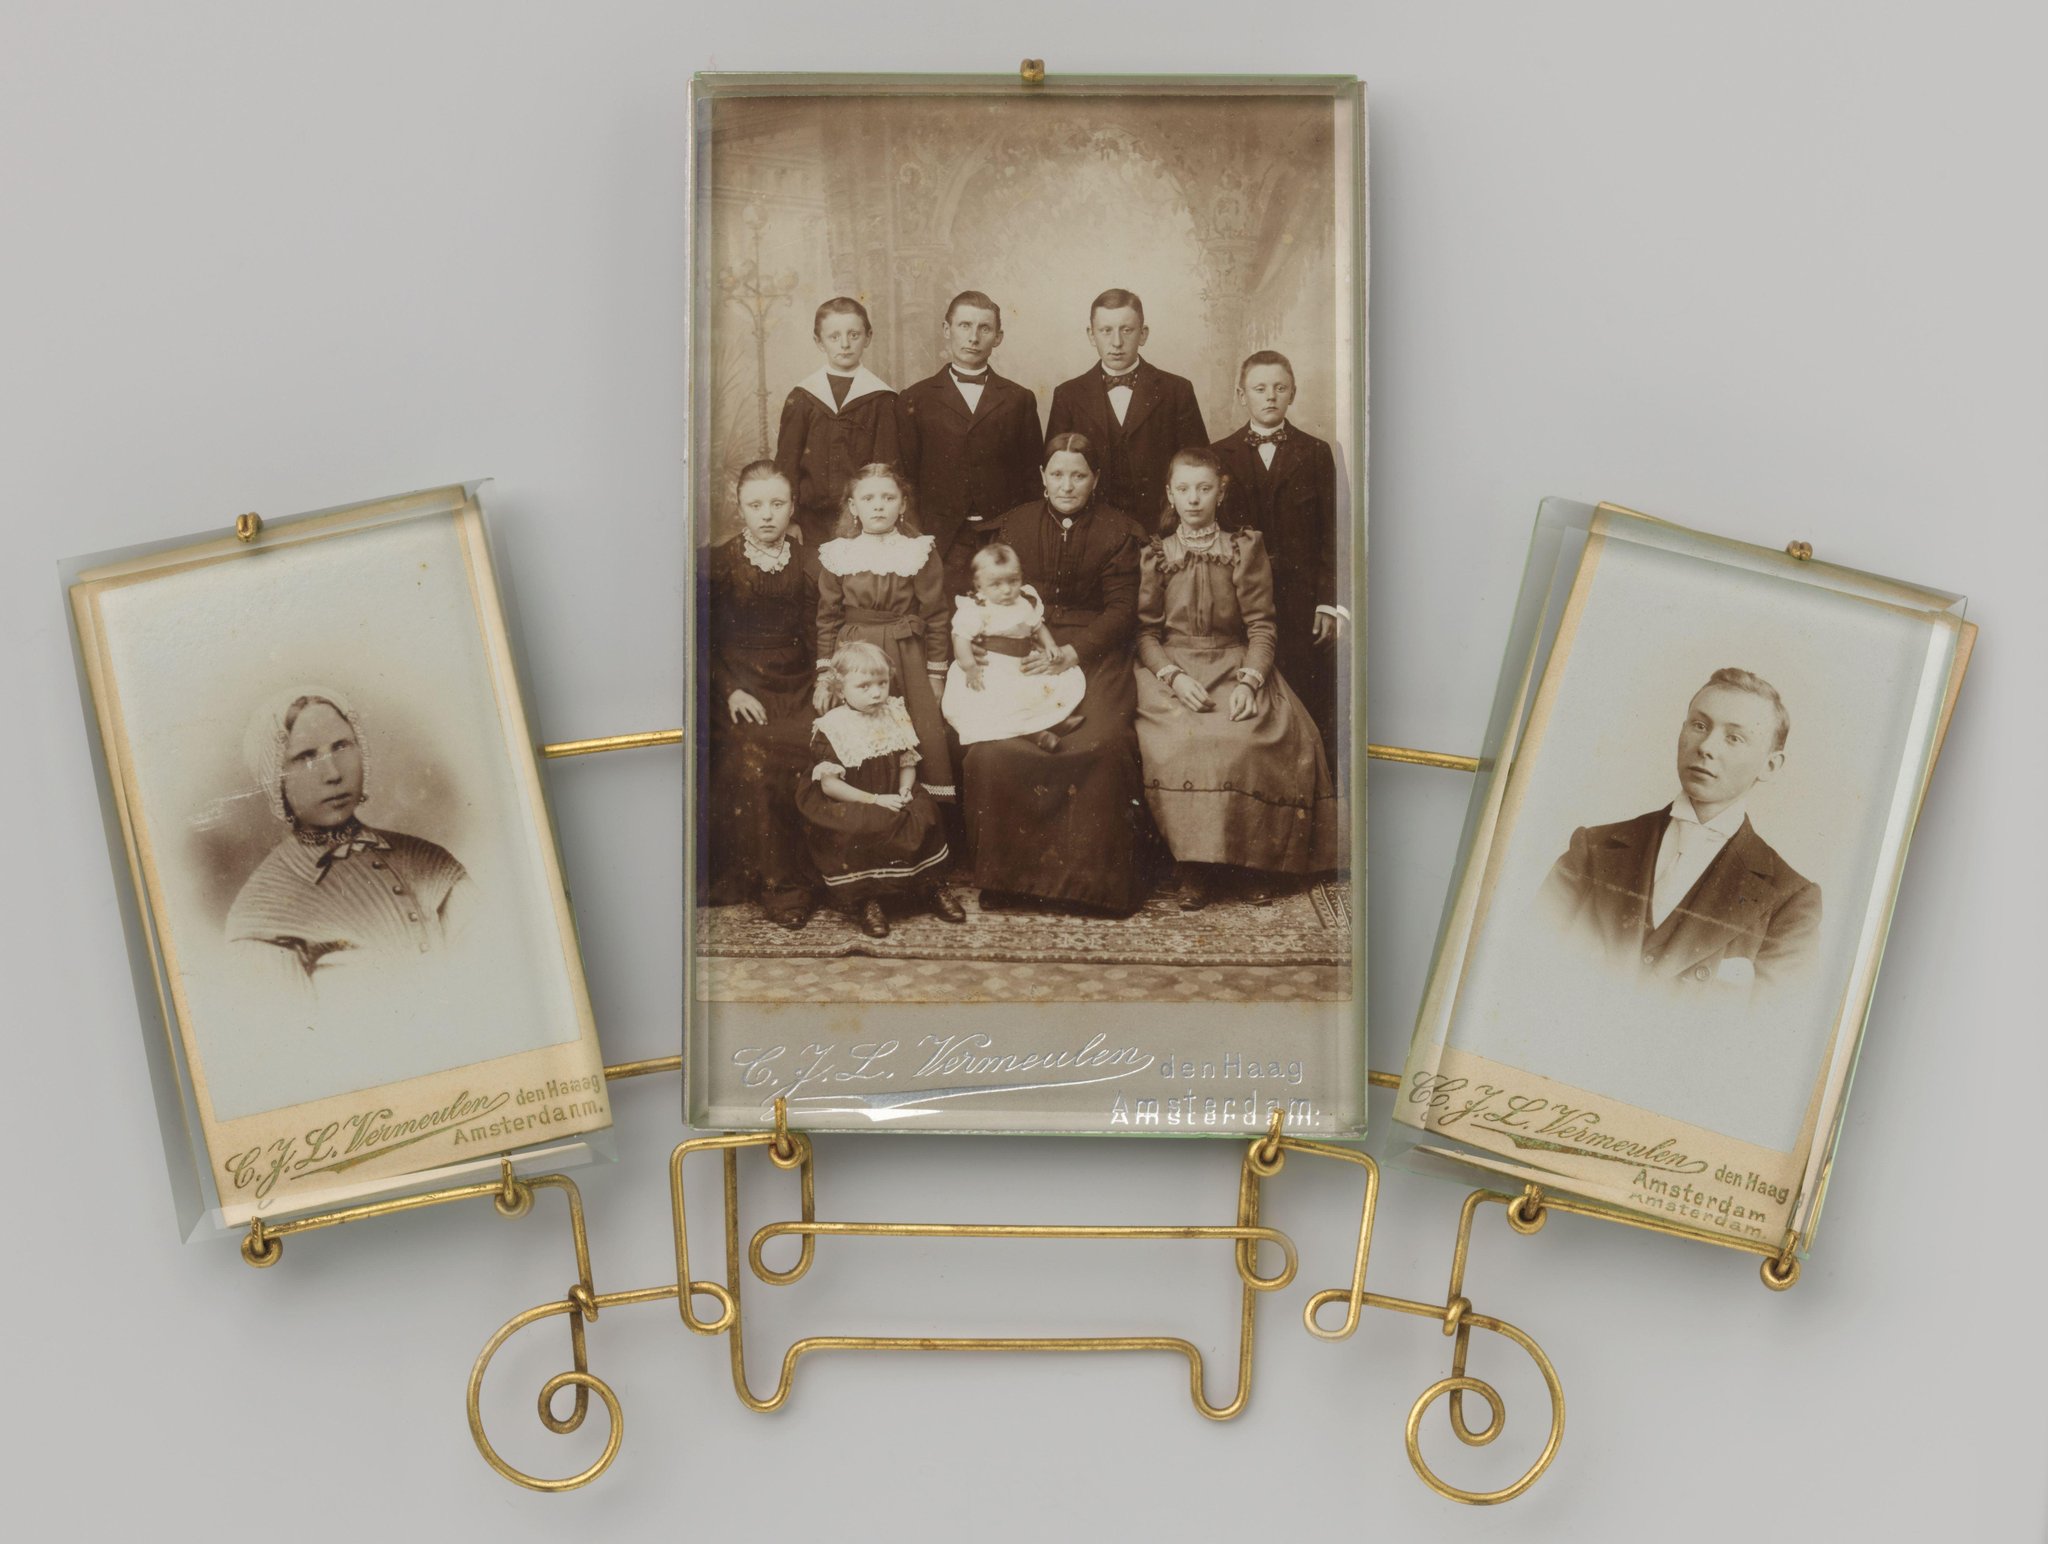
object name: carte de visite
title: Portret van een onbekende jonge vrouw in klederdracht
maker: cornelis johannes lodewicus vermeulen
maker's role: fotograaf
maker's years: 1861-1936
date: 1880-1900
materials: paper, cardboard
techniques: collodion silver print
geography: amsterdam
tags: adolescent, young woman, maiden, anonymous historical person portrayed, folk costume, regional costume, amsterdam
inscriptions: inscription: ‘Toussaintkade 11 Den Haag Heerenstraat 6 Amsterdam’